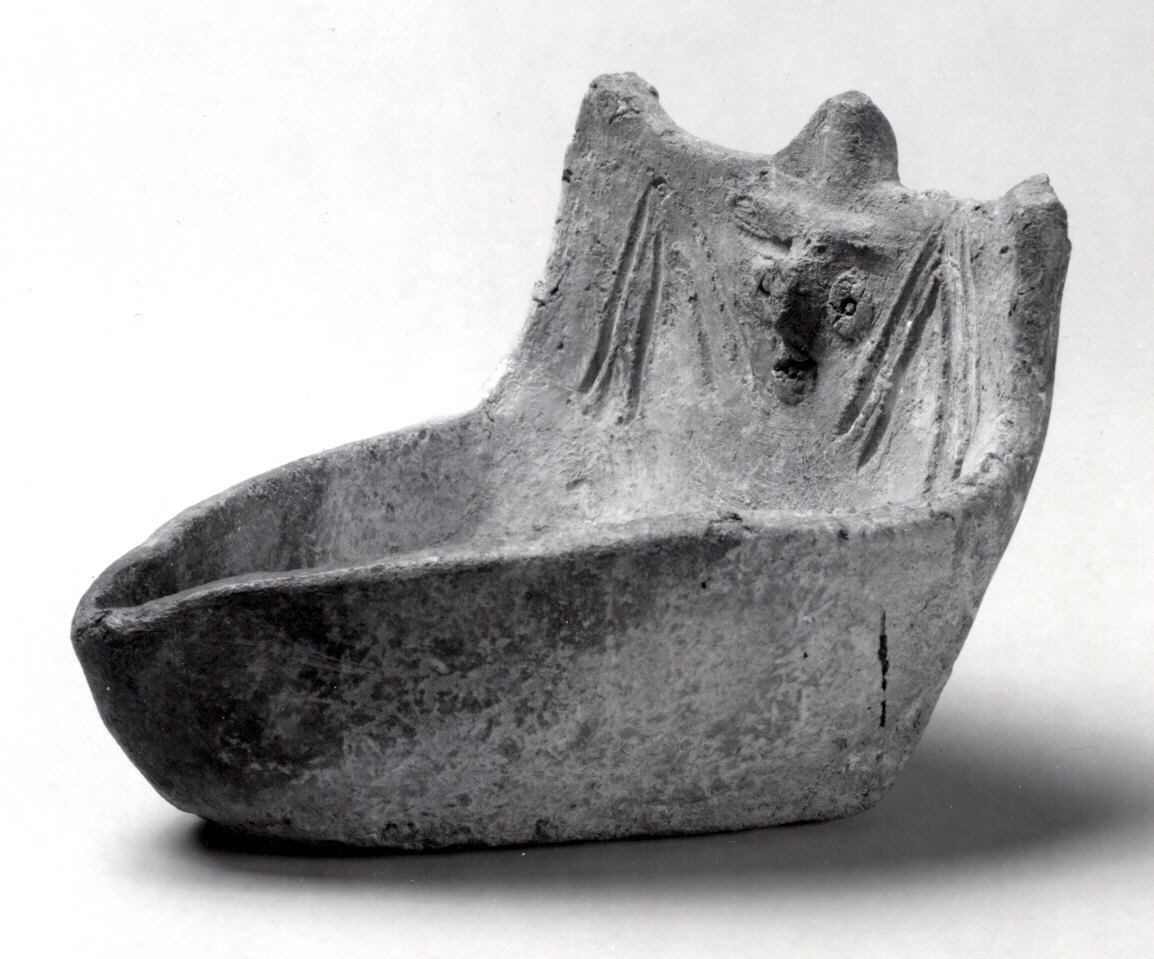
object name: lamp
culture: iranian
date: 1000-1 BCE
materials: ceramic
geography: iran